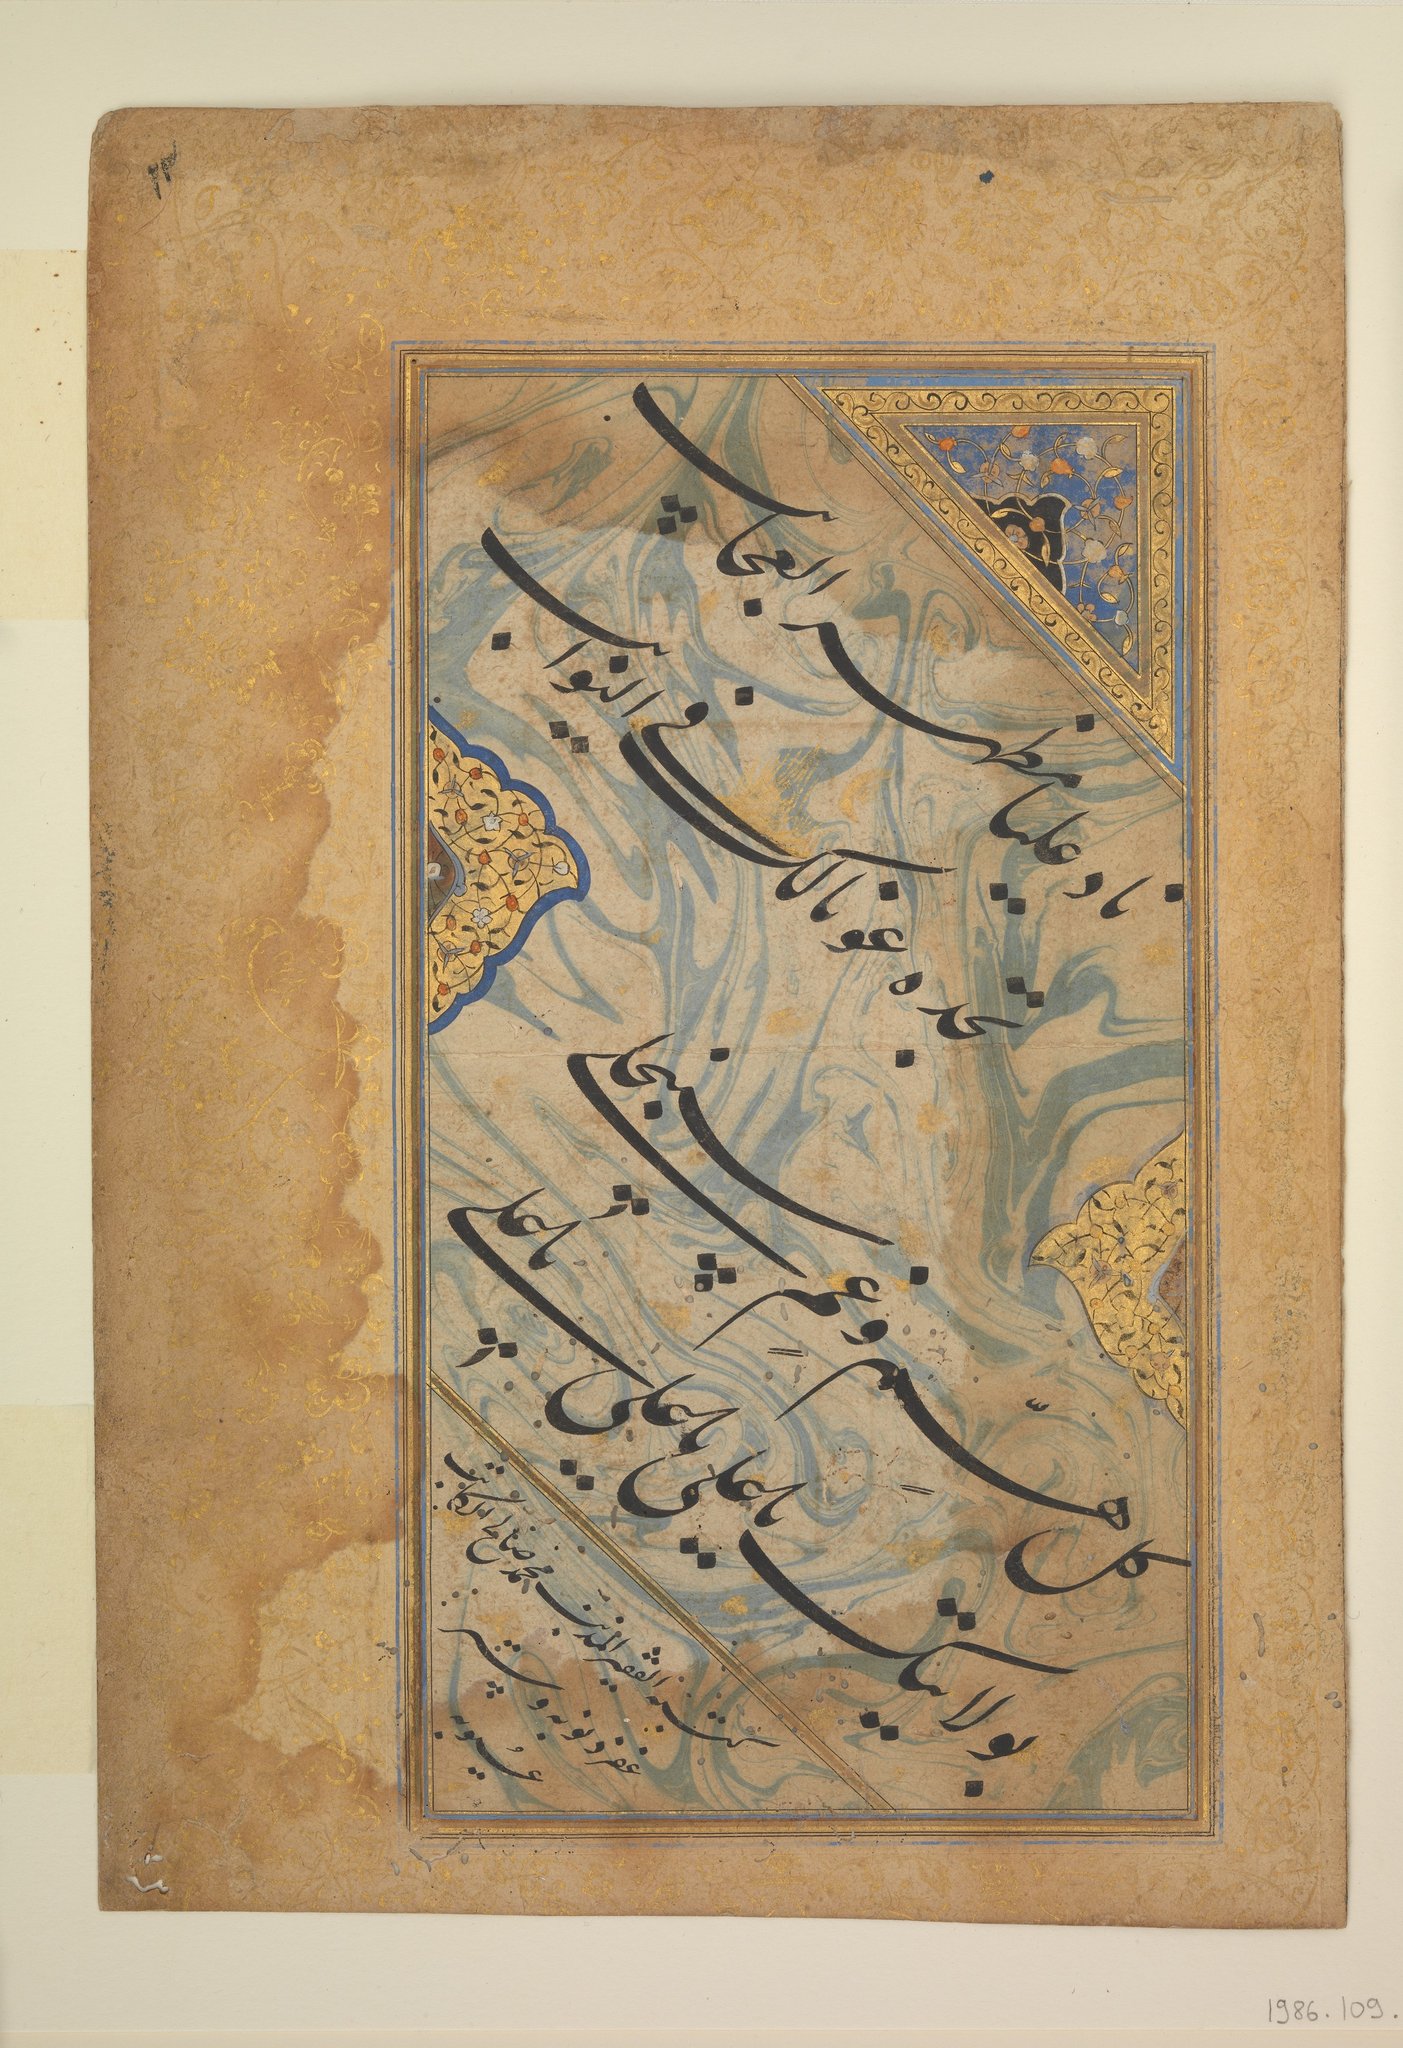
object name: non illustrated album leaf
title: Album Leaf with Shi'a Invocation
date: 1601-1700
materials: gold, ink, paper, watercolor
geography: northern india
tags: arabic,calligraphy